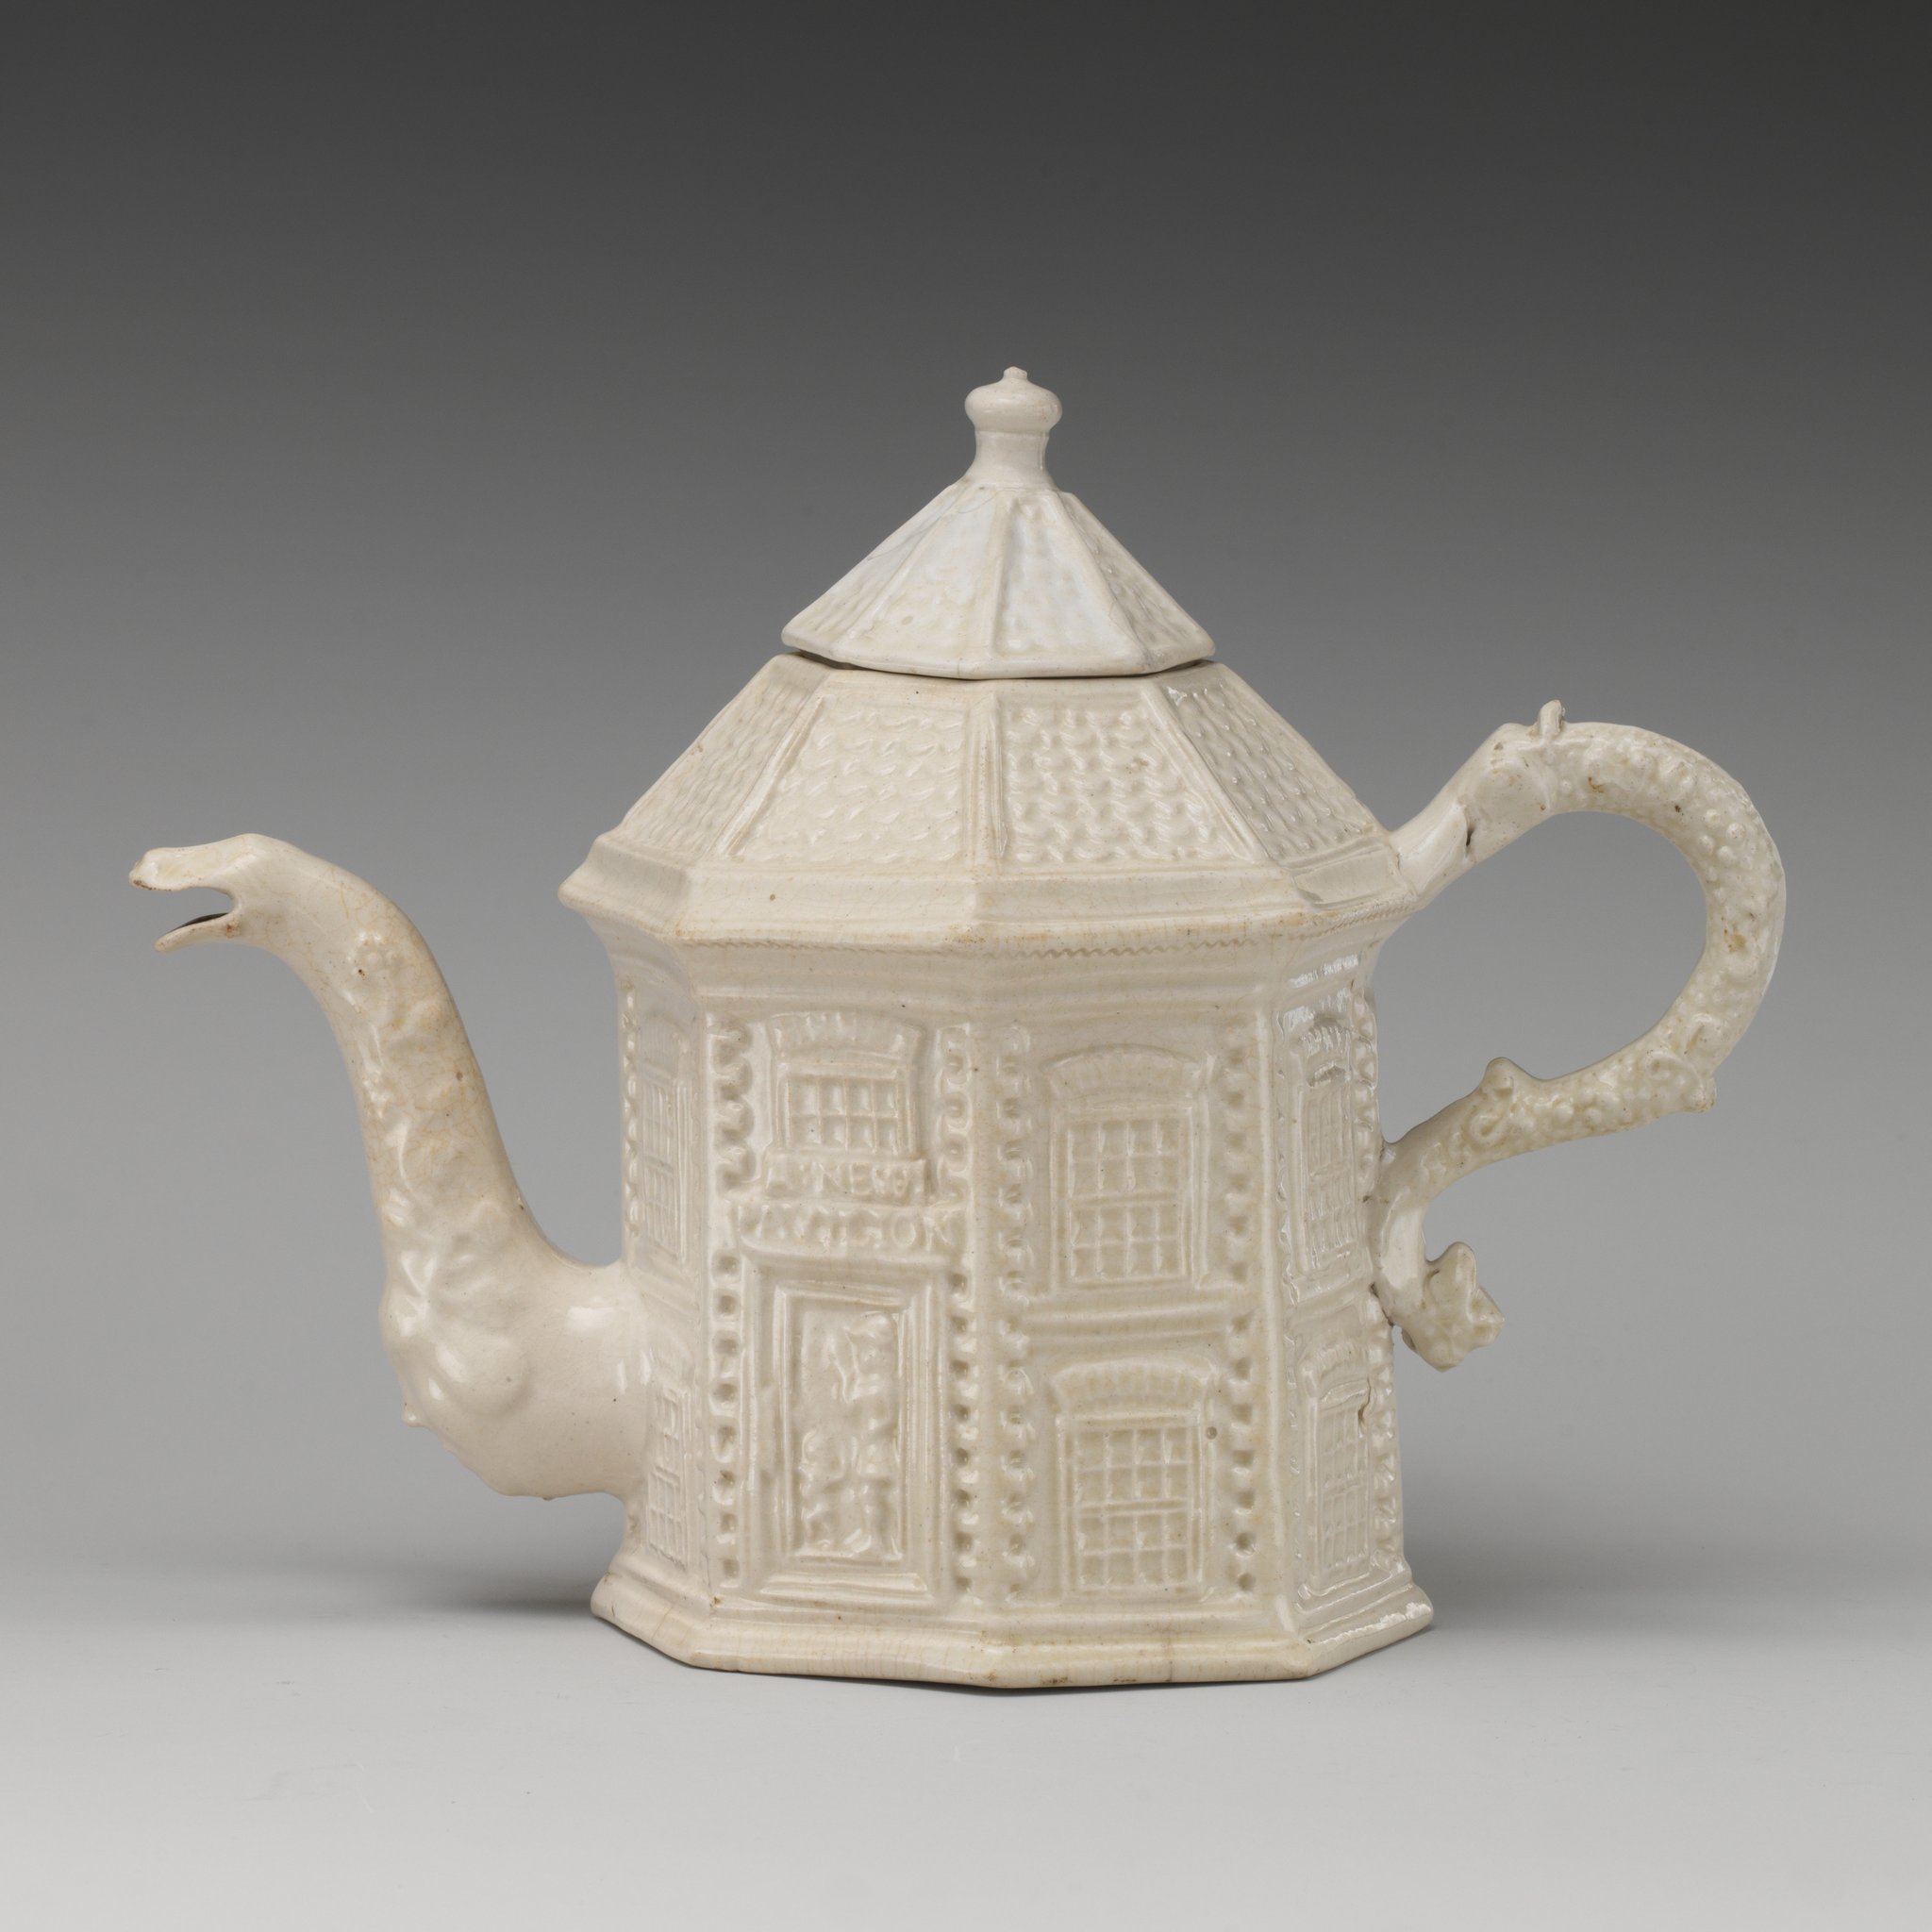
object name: teapot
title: Teapot in the form of an octagonal pavilion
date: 1745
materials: stoneware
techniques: salt glaze